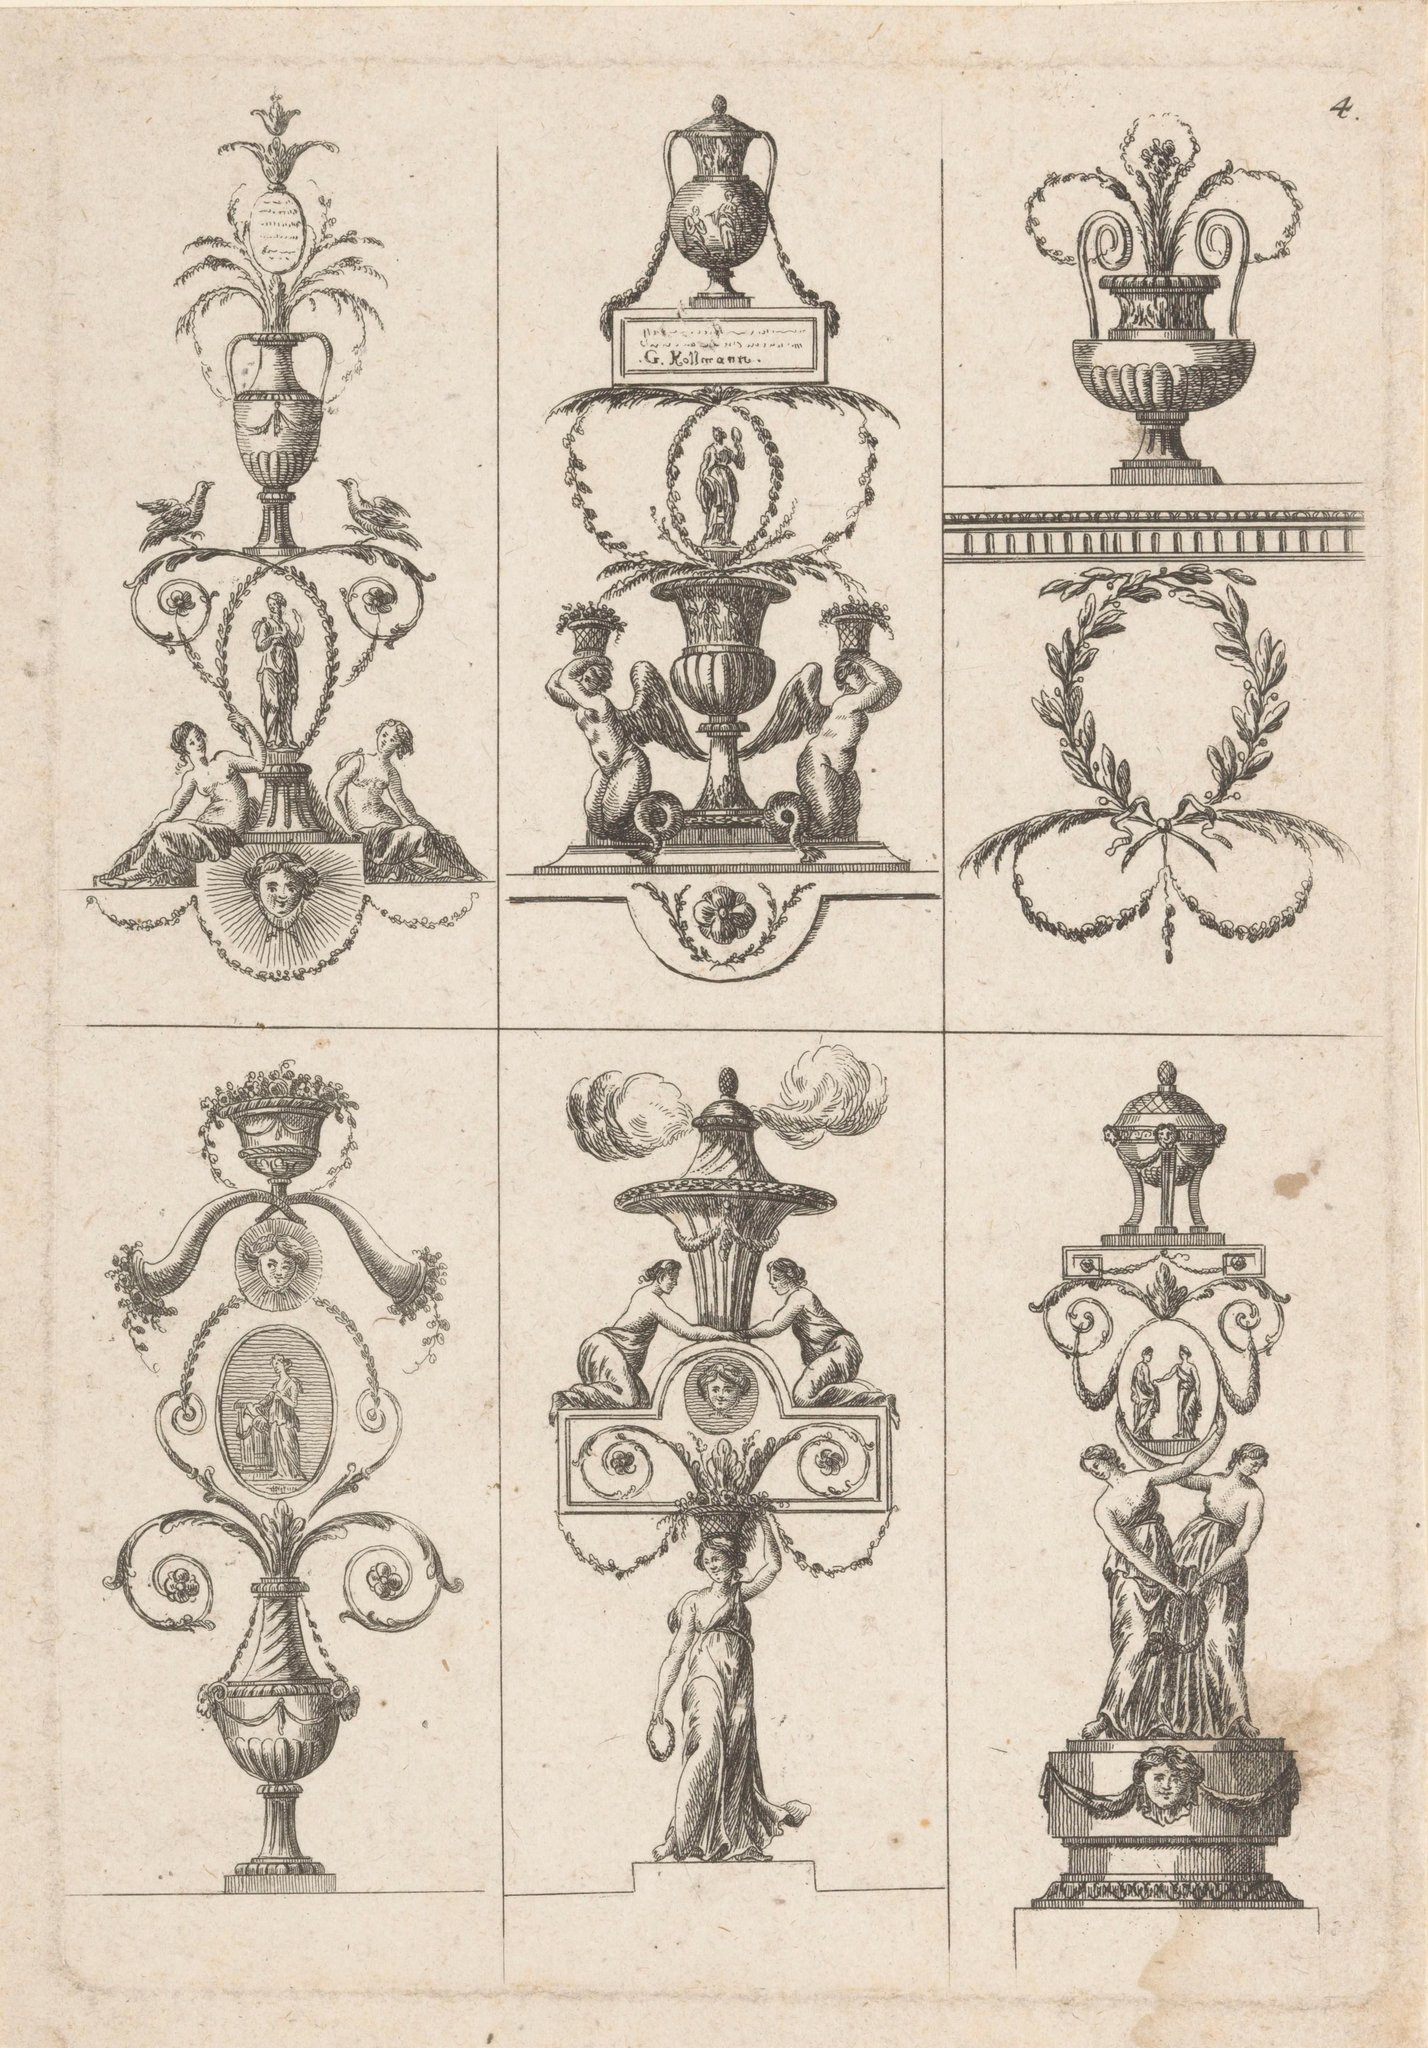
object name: print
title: Zes scènes met arabesken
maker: kollmann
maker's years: 1700-1799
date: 1746-1800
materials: paper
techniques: etching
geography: paris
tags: ornament ~ arabesque, vase ~ ornament, postures of the human figure - aa - female human figure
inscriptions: collector's mark: Lugt 2760, collector's mark: Lugt 2228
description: Zes scènes met arabesken, staande en zittende vrouwelijke figuren en vazen.